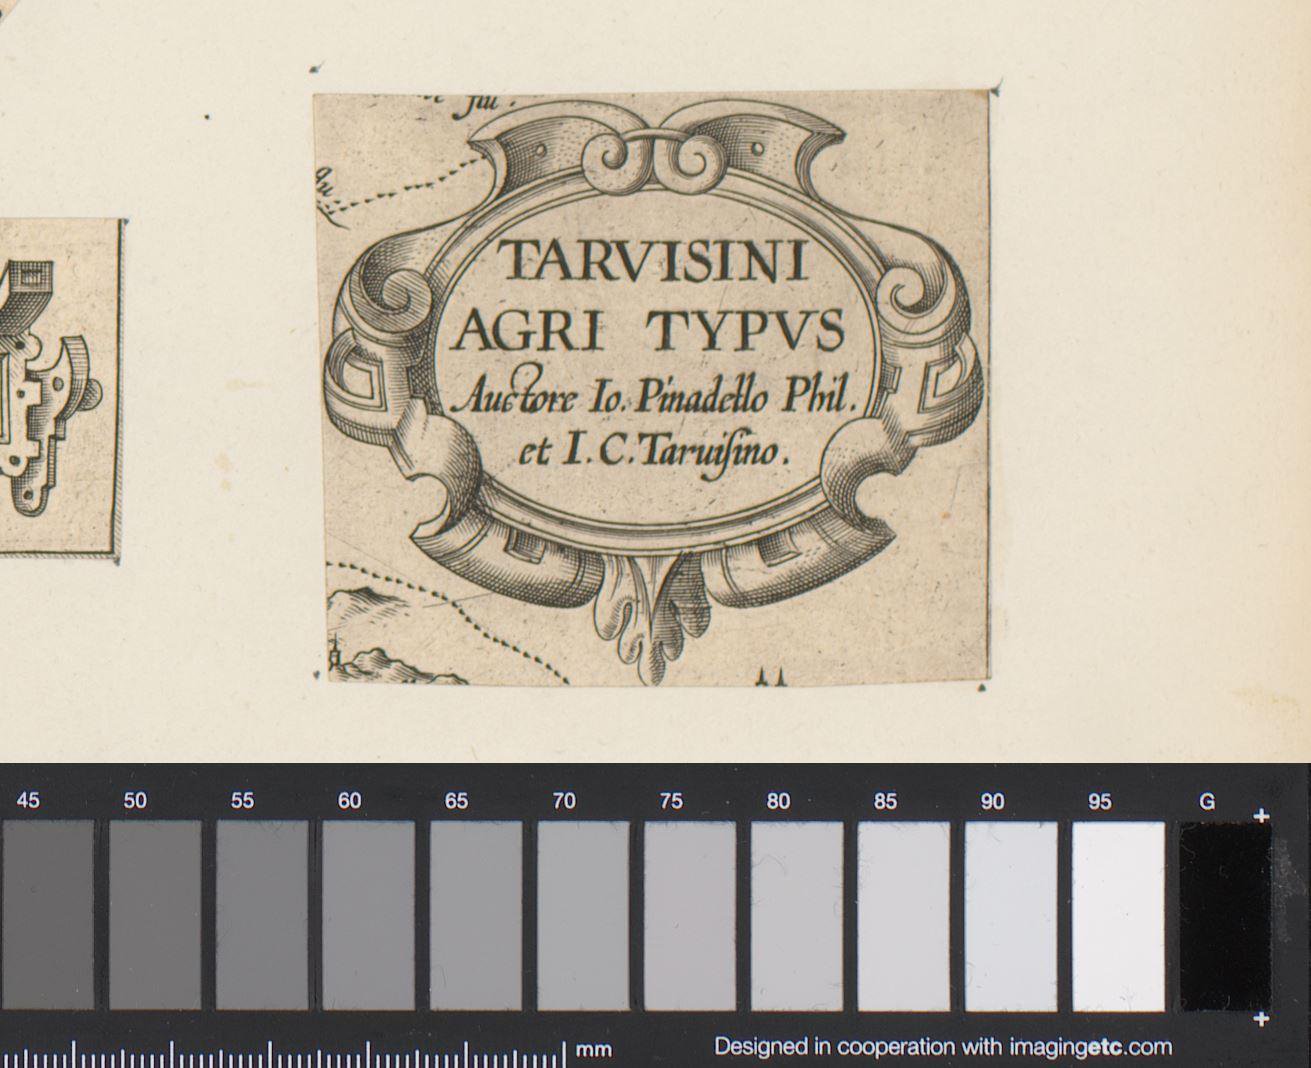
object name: print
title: Theatrum Orbis Terrarum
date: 1595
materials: paper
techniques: engraving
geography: antwerp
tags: scrollwork, strapwork ~ ornament, ornament ~ cartouche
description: Ovale cartouche met rolwerk. De cartouche is een fragment van een kaart van Padua en Tarvisio. De prent maakt deel uit van een album.